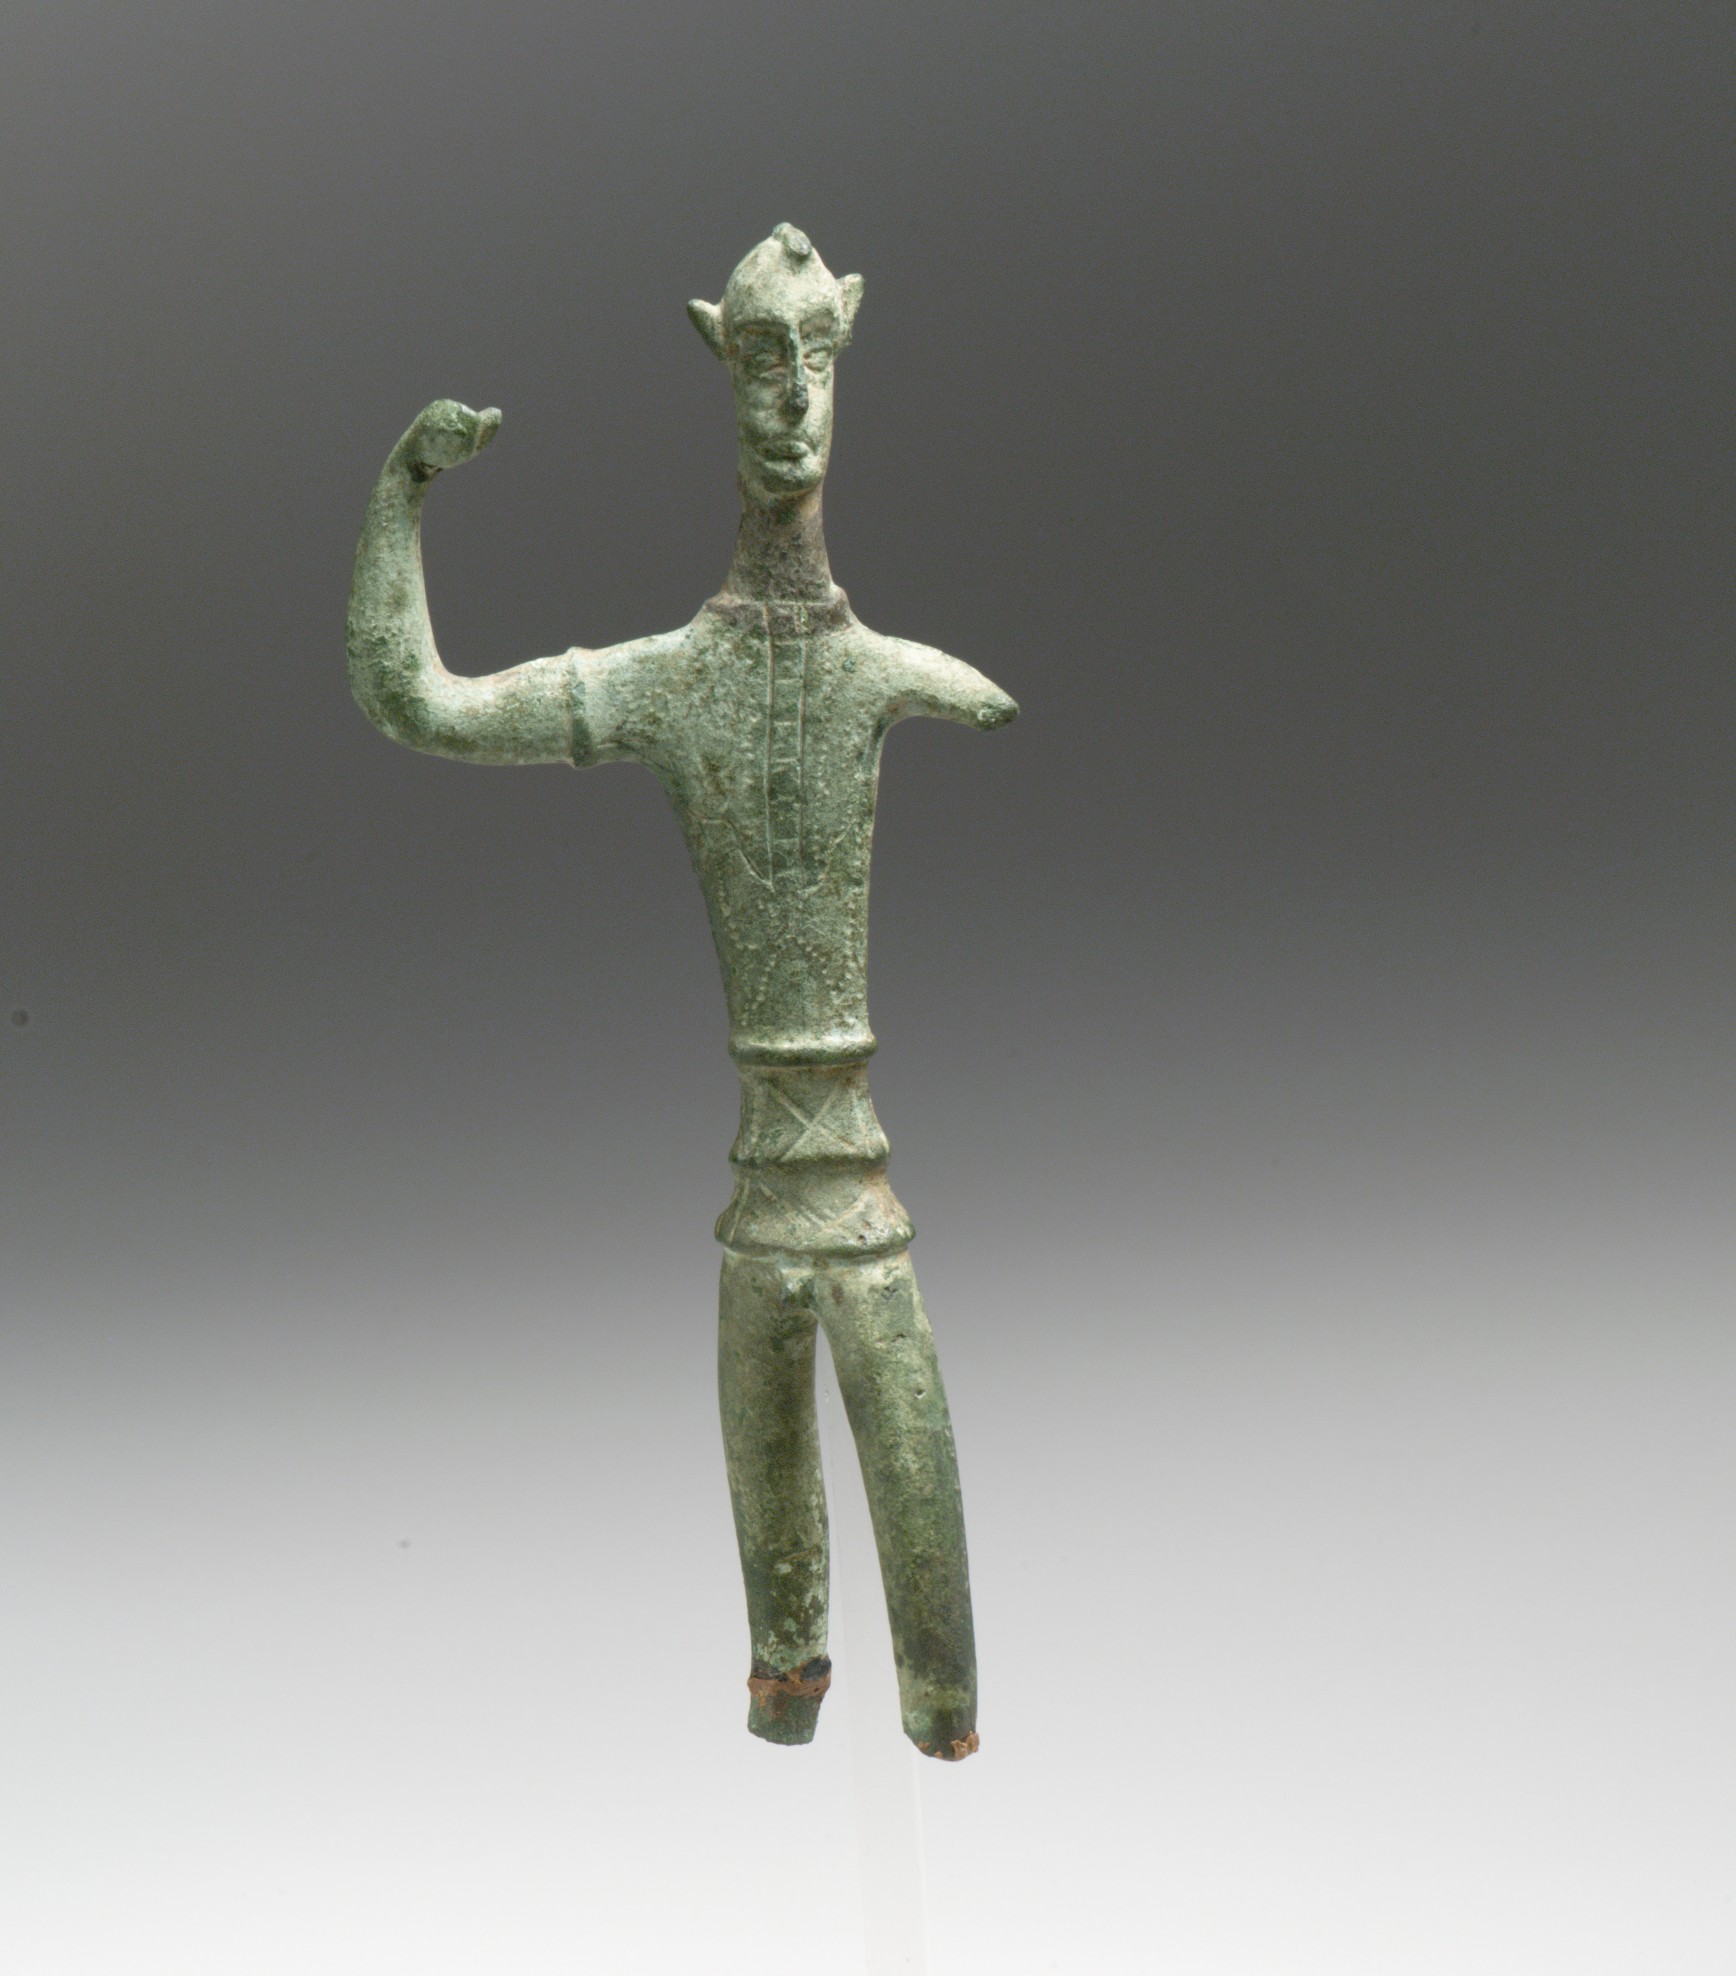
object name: statuette of are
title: Bronze statuette of a warrior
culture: etruscan or italic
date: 700-501 BCE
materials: bronze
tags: warriors